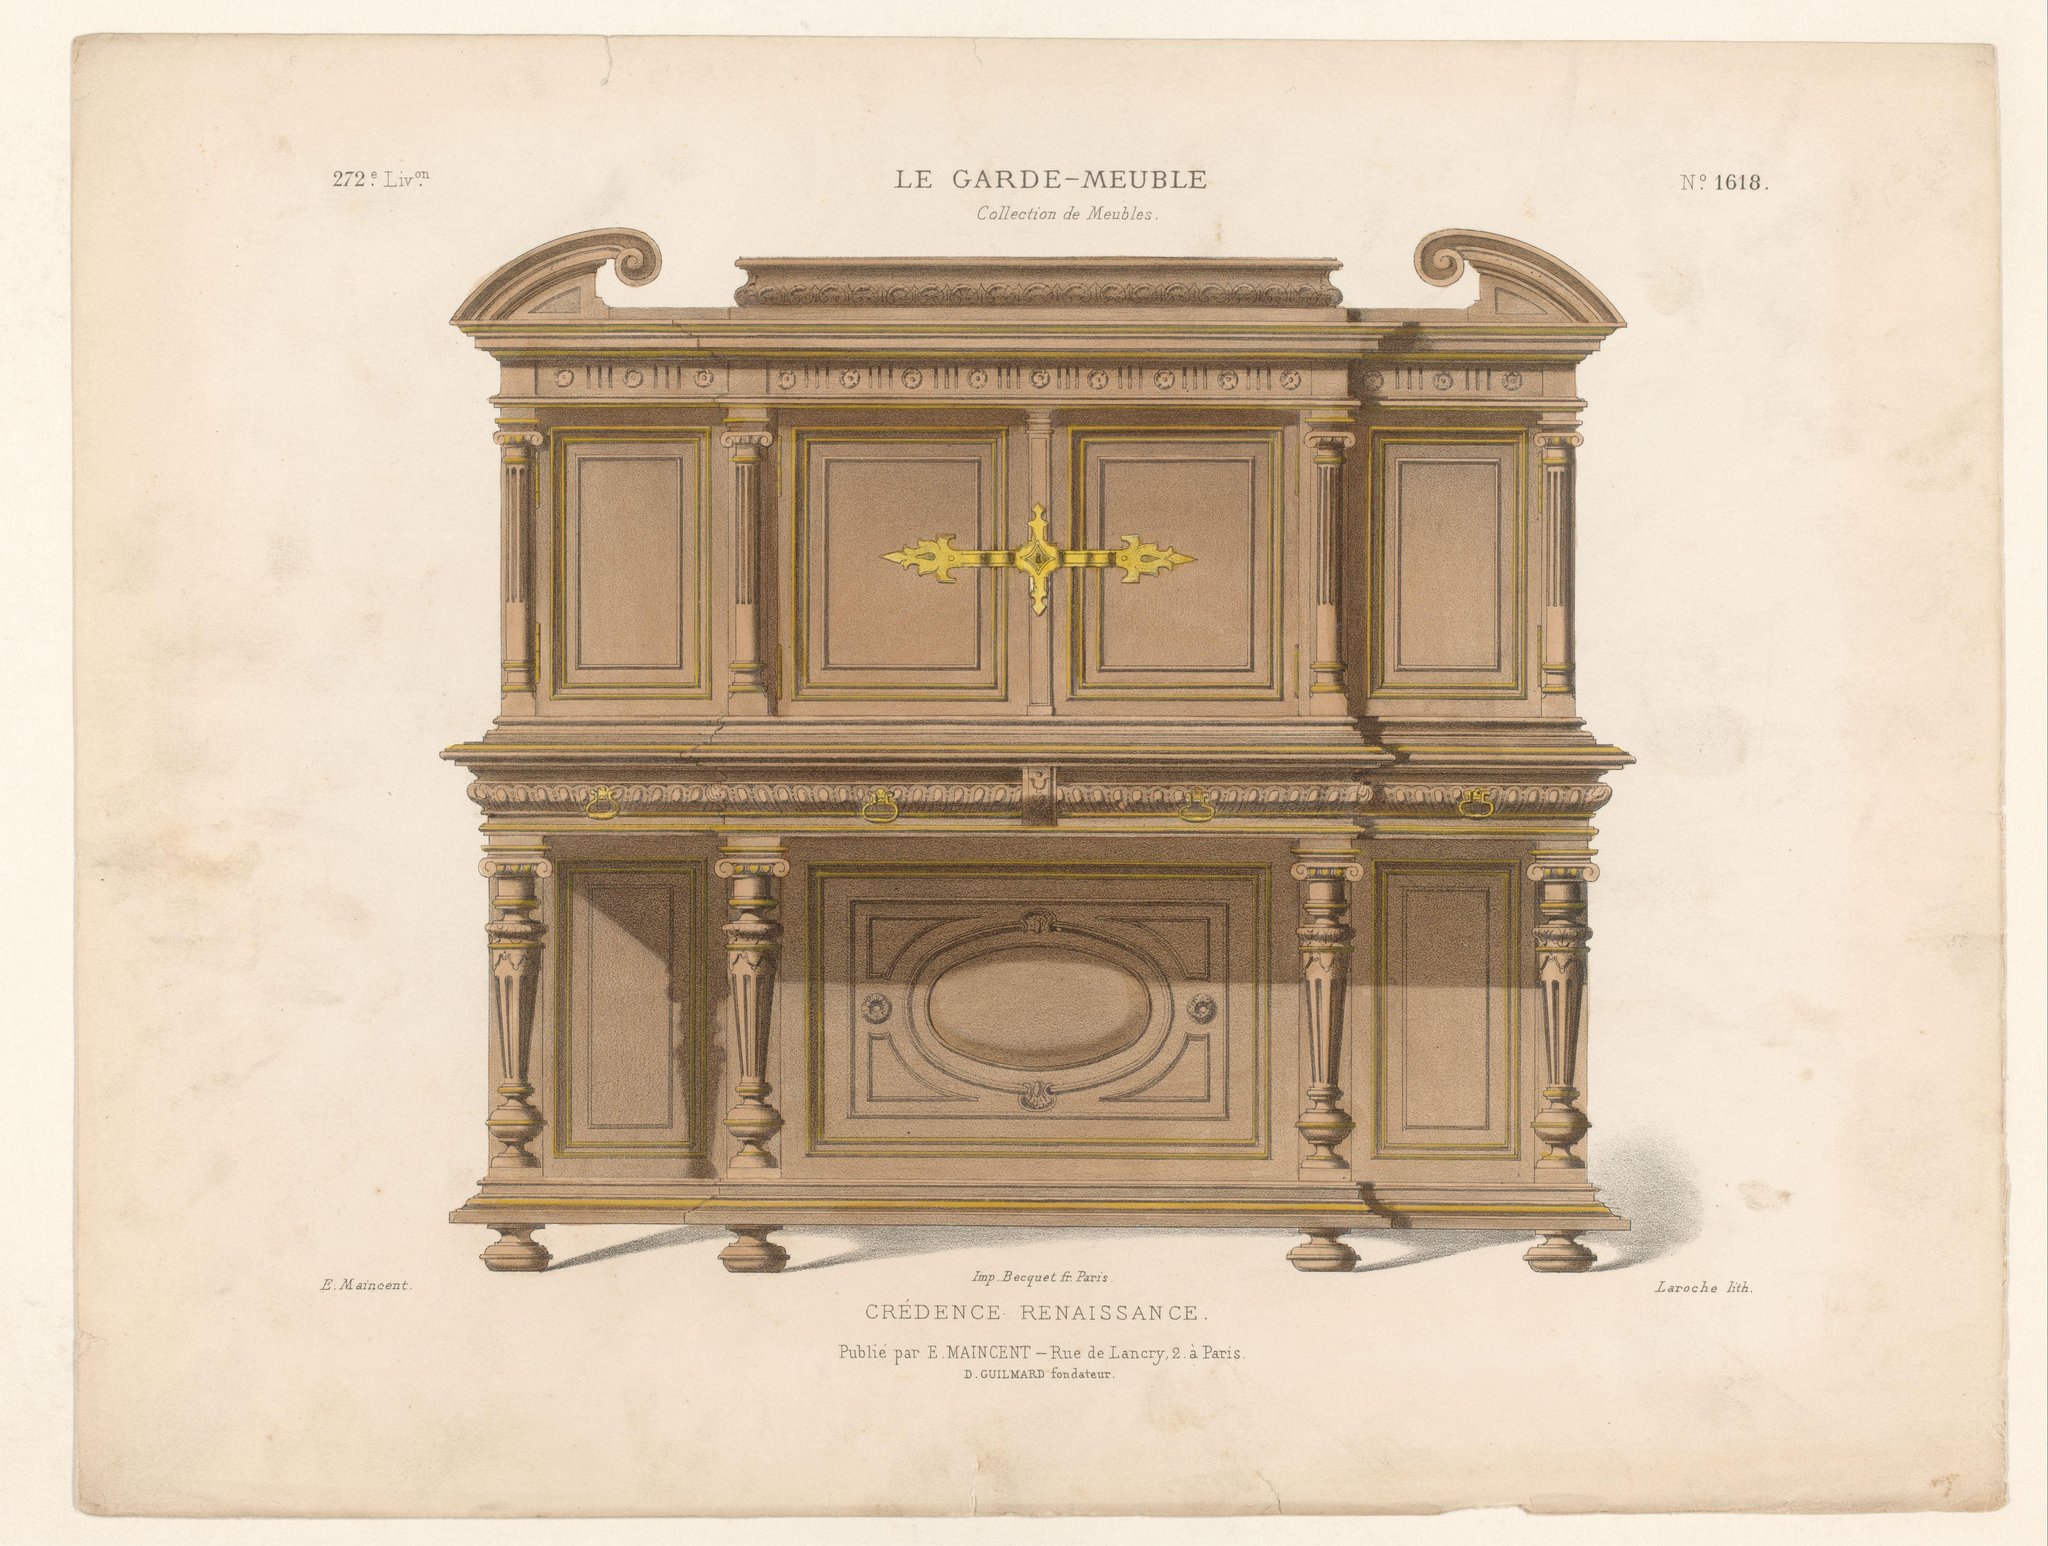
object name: print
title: Le garde-meuble / Collection de Meubles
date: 1885-1895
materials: paper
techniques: hand coloring, lithograph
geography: paris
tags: furniture for storage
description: Ieder Livraison in de serie Le Garde-Meuble bevat negen platen: drie 'sièges' (zitmeubels), drie 'meubles' (diverse meubels zoals tafels en kasten) en drie 'tentures' (gordijnen en draperieën).